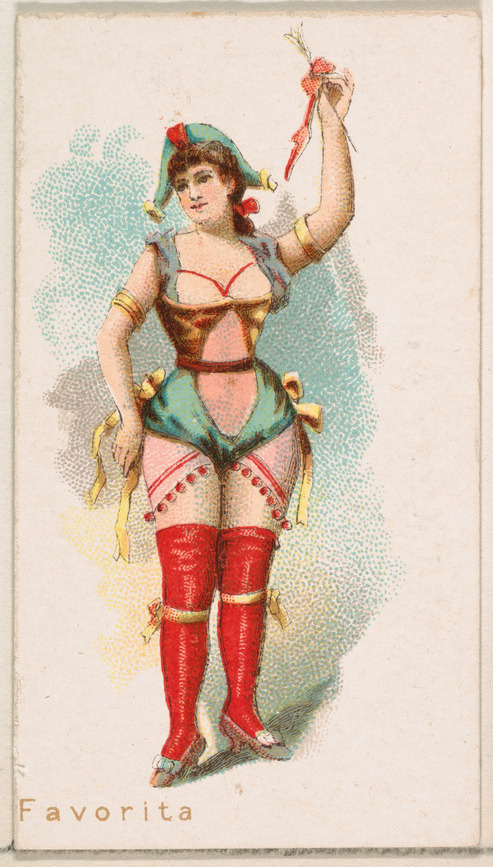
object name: print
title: Favorita, from the Ballet Queens series (N182) issued by Wm. S. Kimball & Co.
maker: william s. kimball & company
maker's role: publisher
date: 1889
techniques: color lithograph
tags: dance,women,dancers